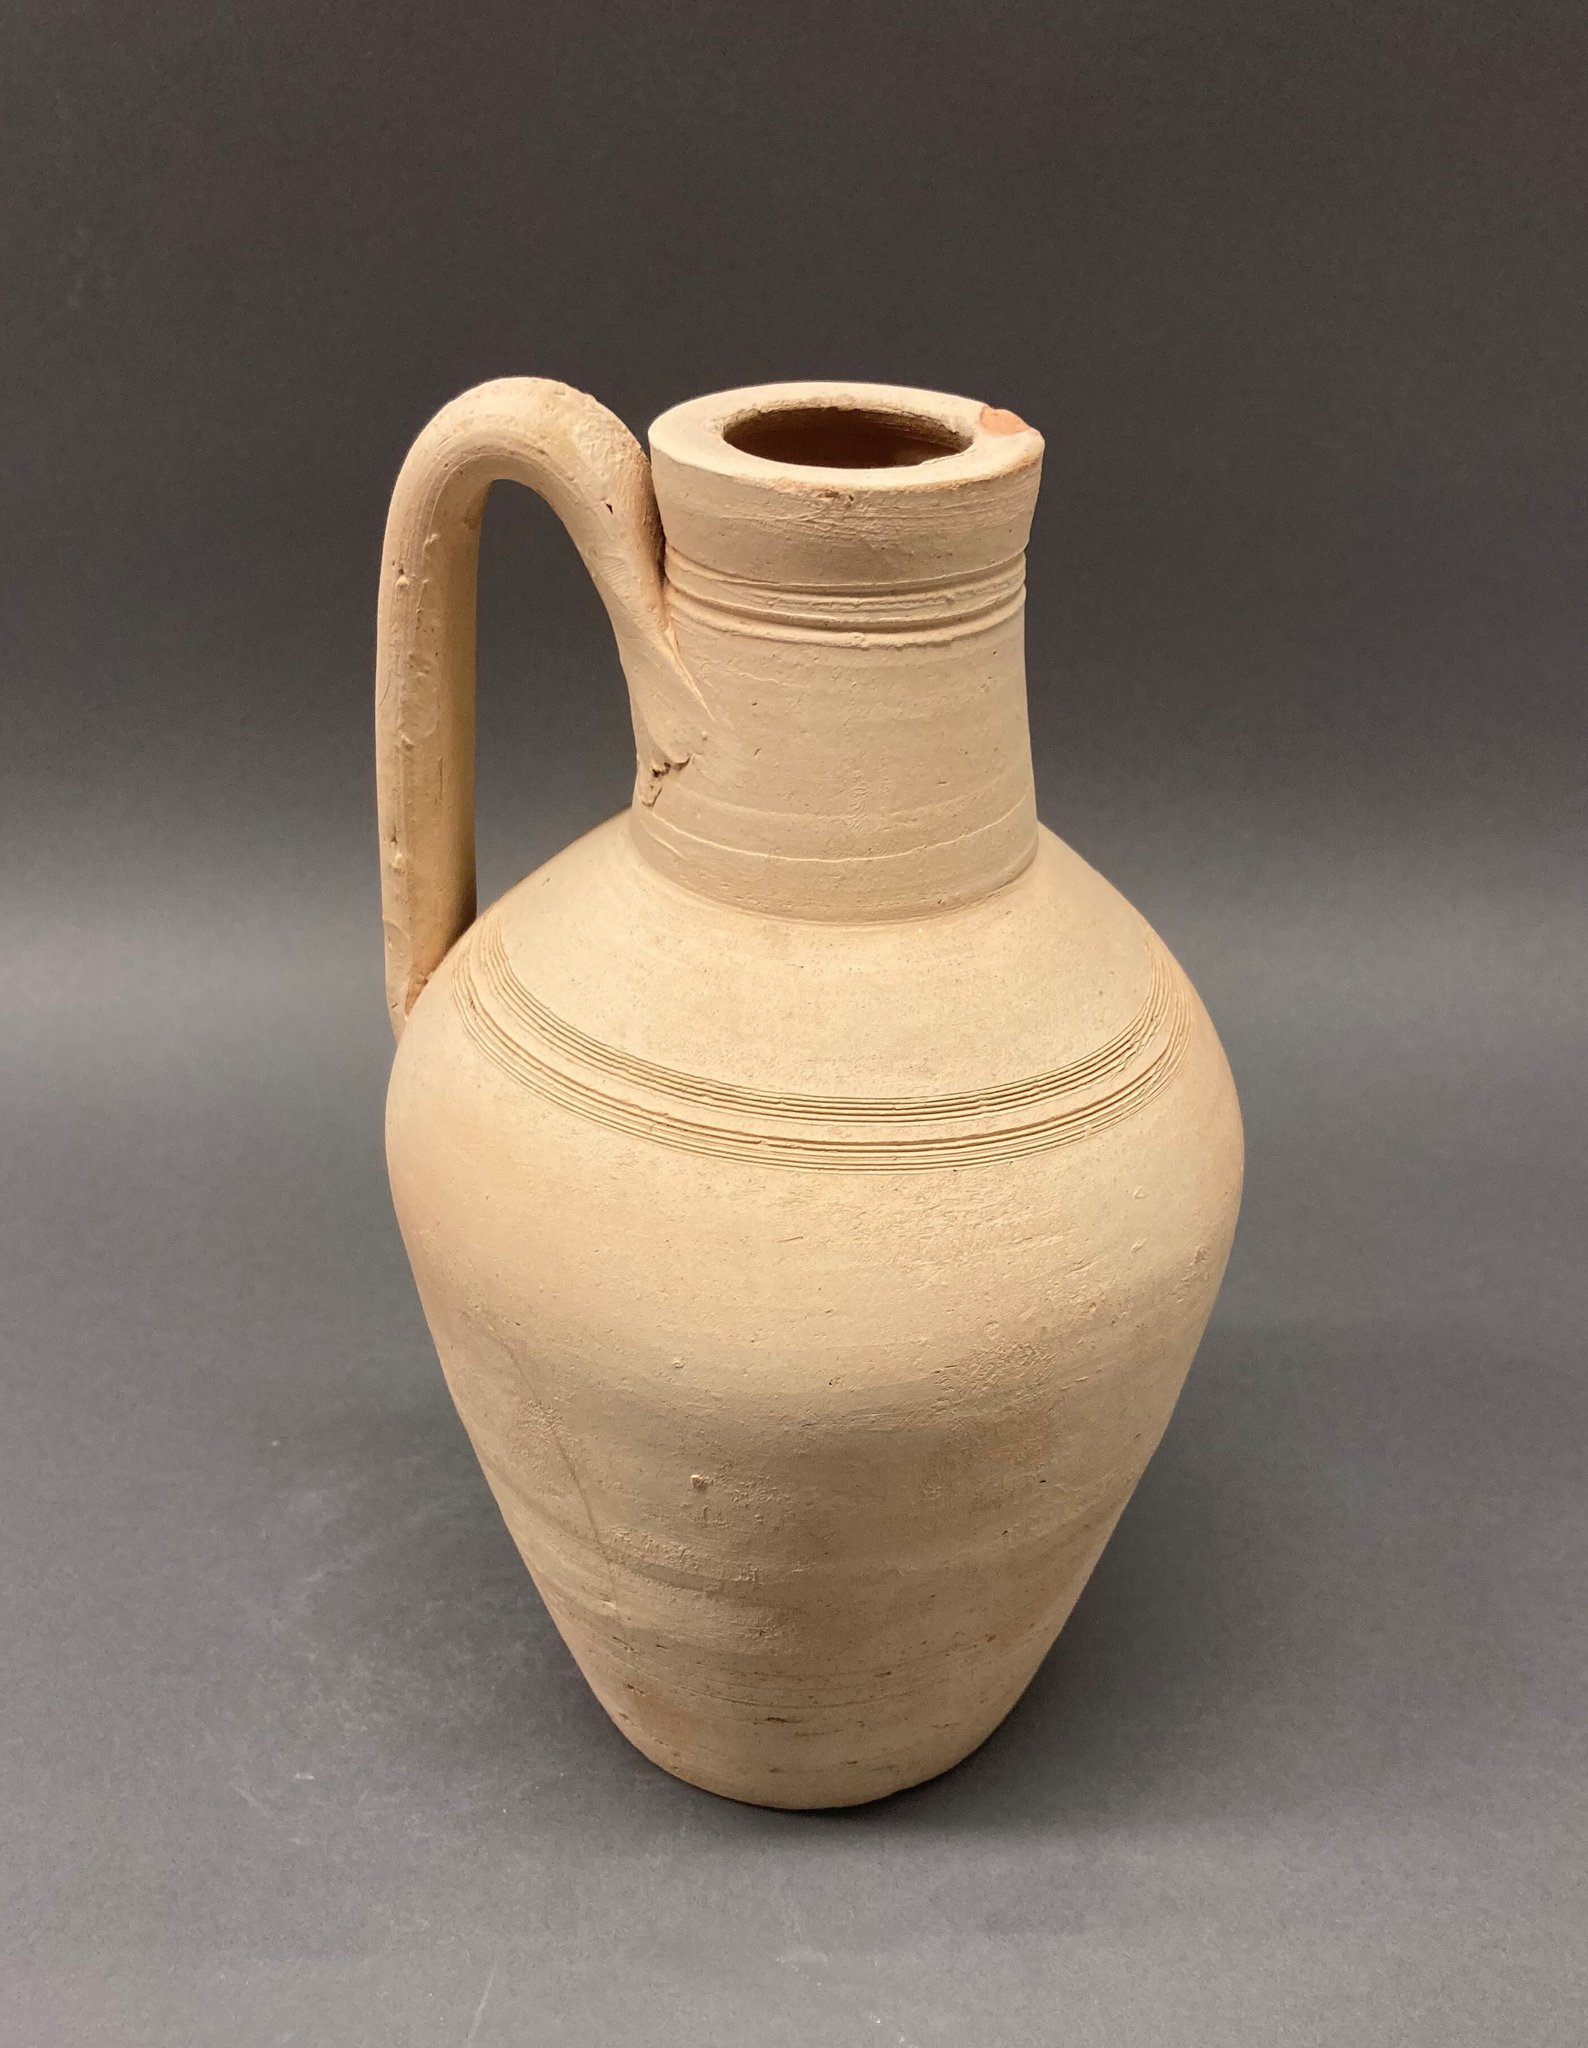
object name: ewer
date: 901-1100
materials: earthenware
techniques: incising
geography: iran